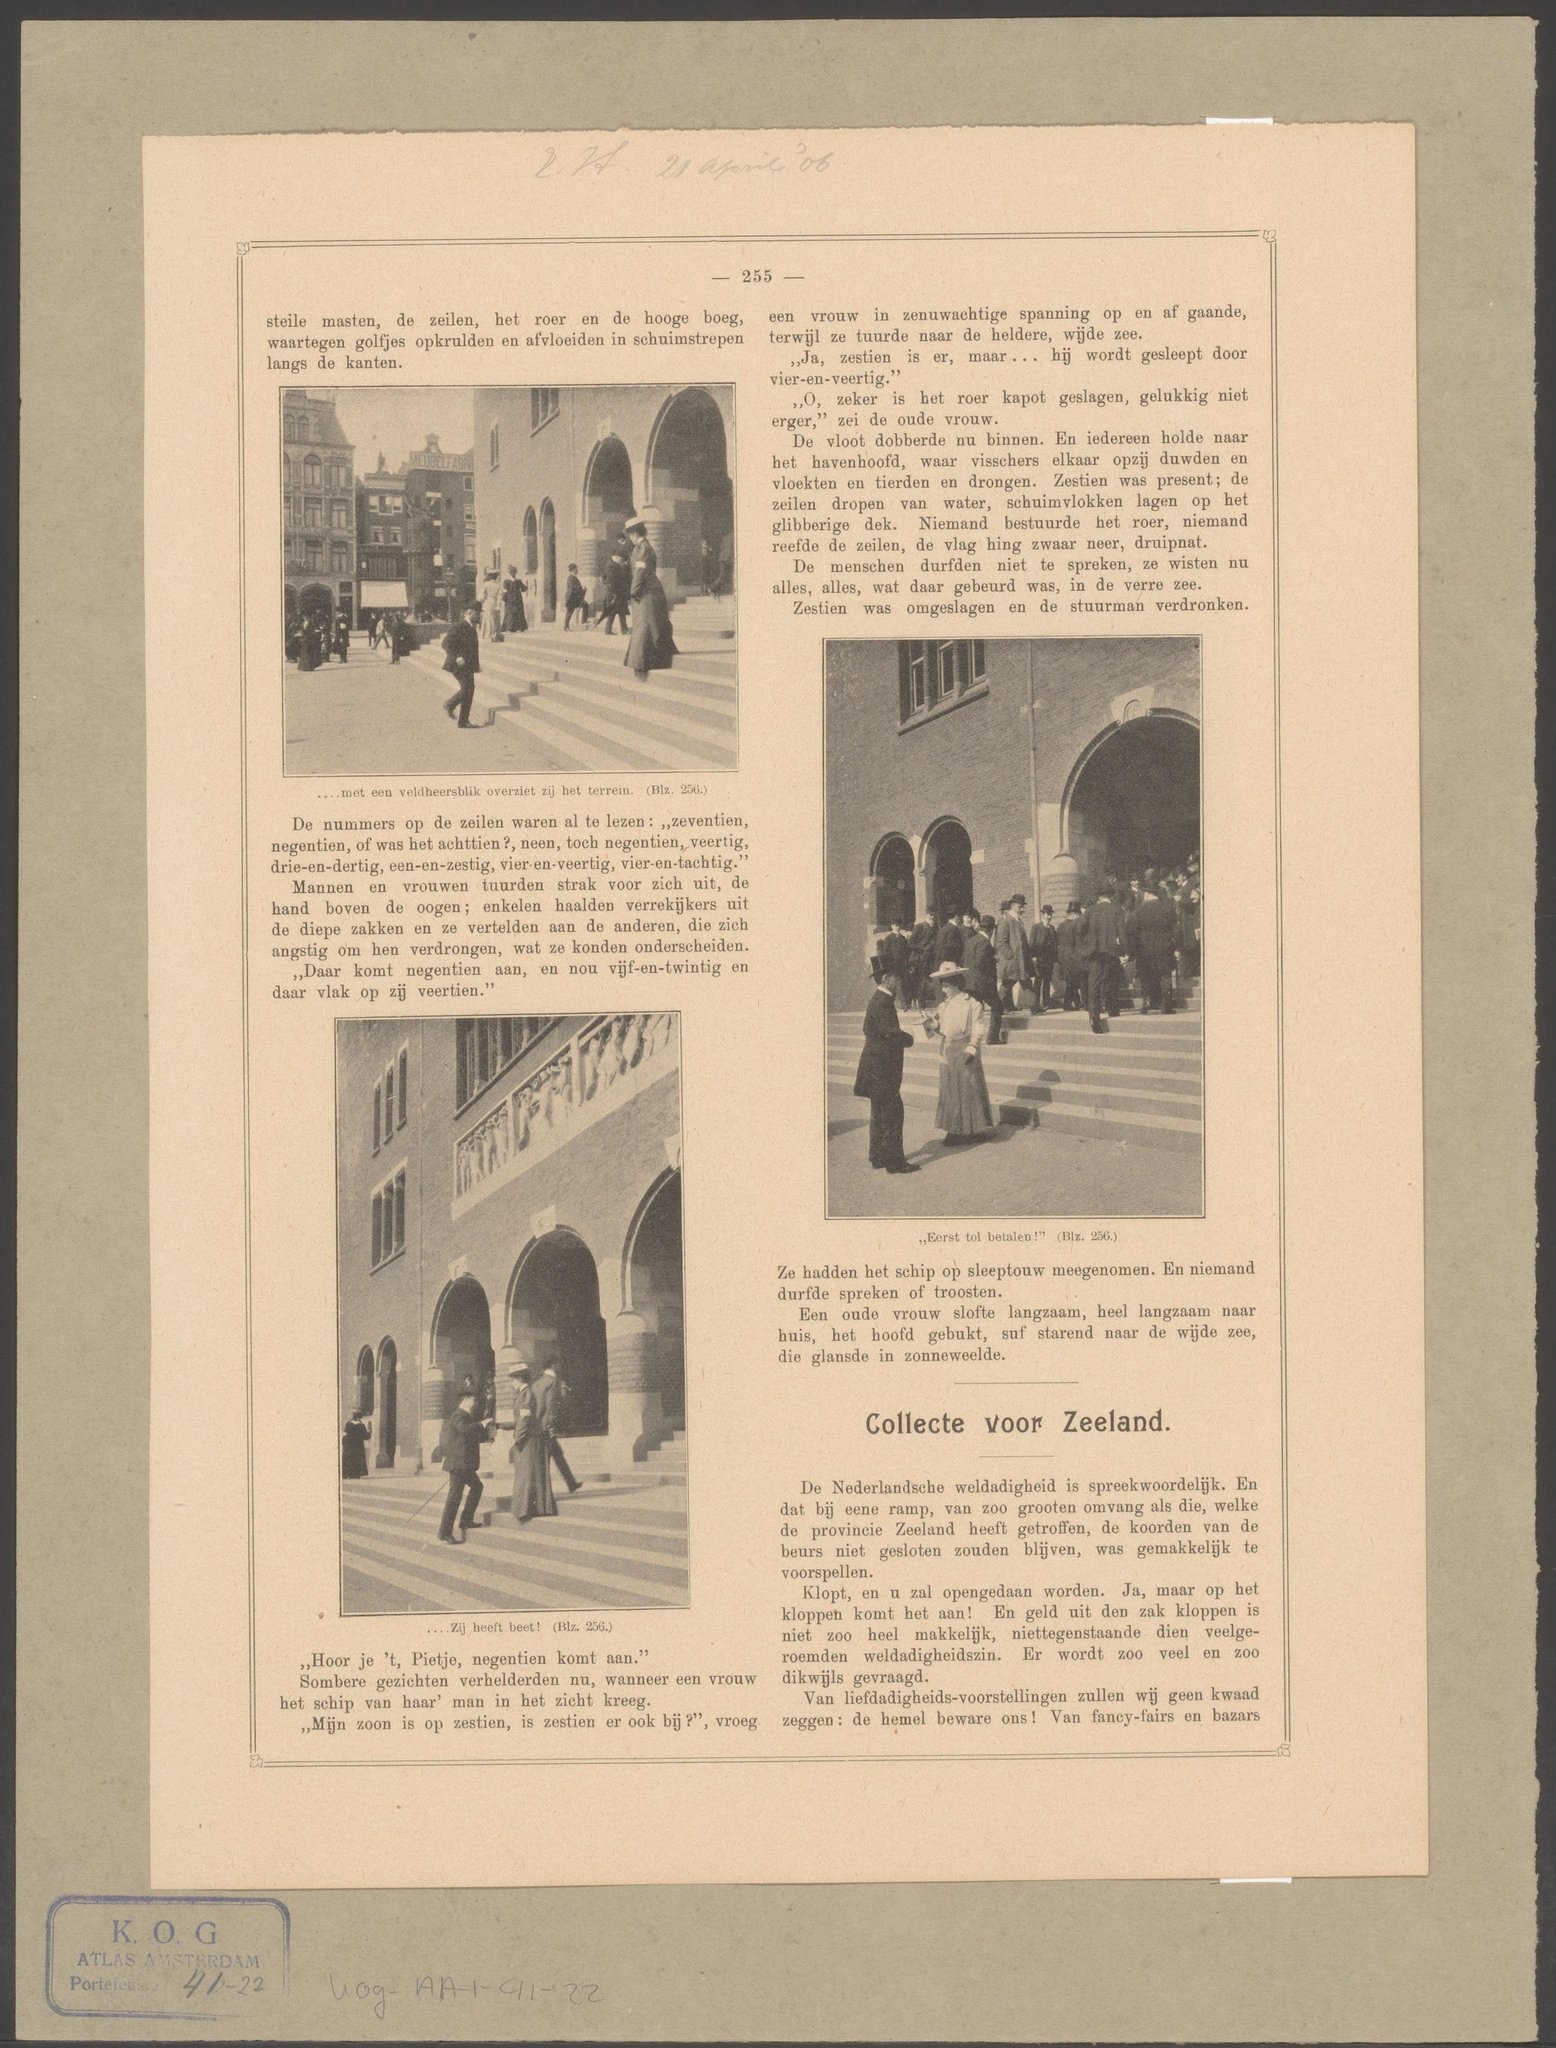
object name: photomechanical print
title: Collecte voor Zeeland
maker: Anonymous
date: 1906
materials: paper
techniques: letterpress printing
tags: offertory-box, offertory-bag, stock exchange, stock-market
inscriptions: collector's mark: Lugt 1461b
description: Drie voorstellingen van de collecte op de trappen van de Beurs van Berlage. Bovenaan genummerd: 255. Onderwerpsrubriek binnen de Atlas Amsterdam: B. Beurs op het Damrak.